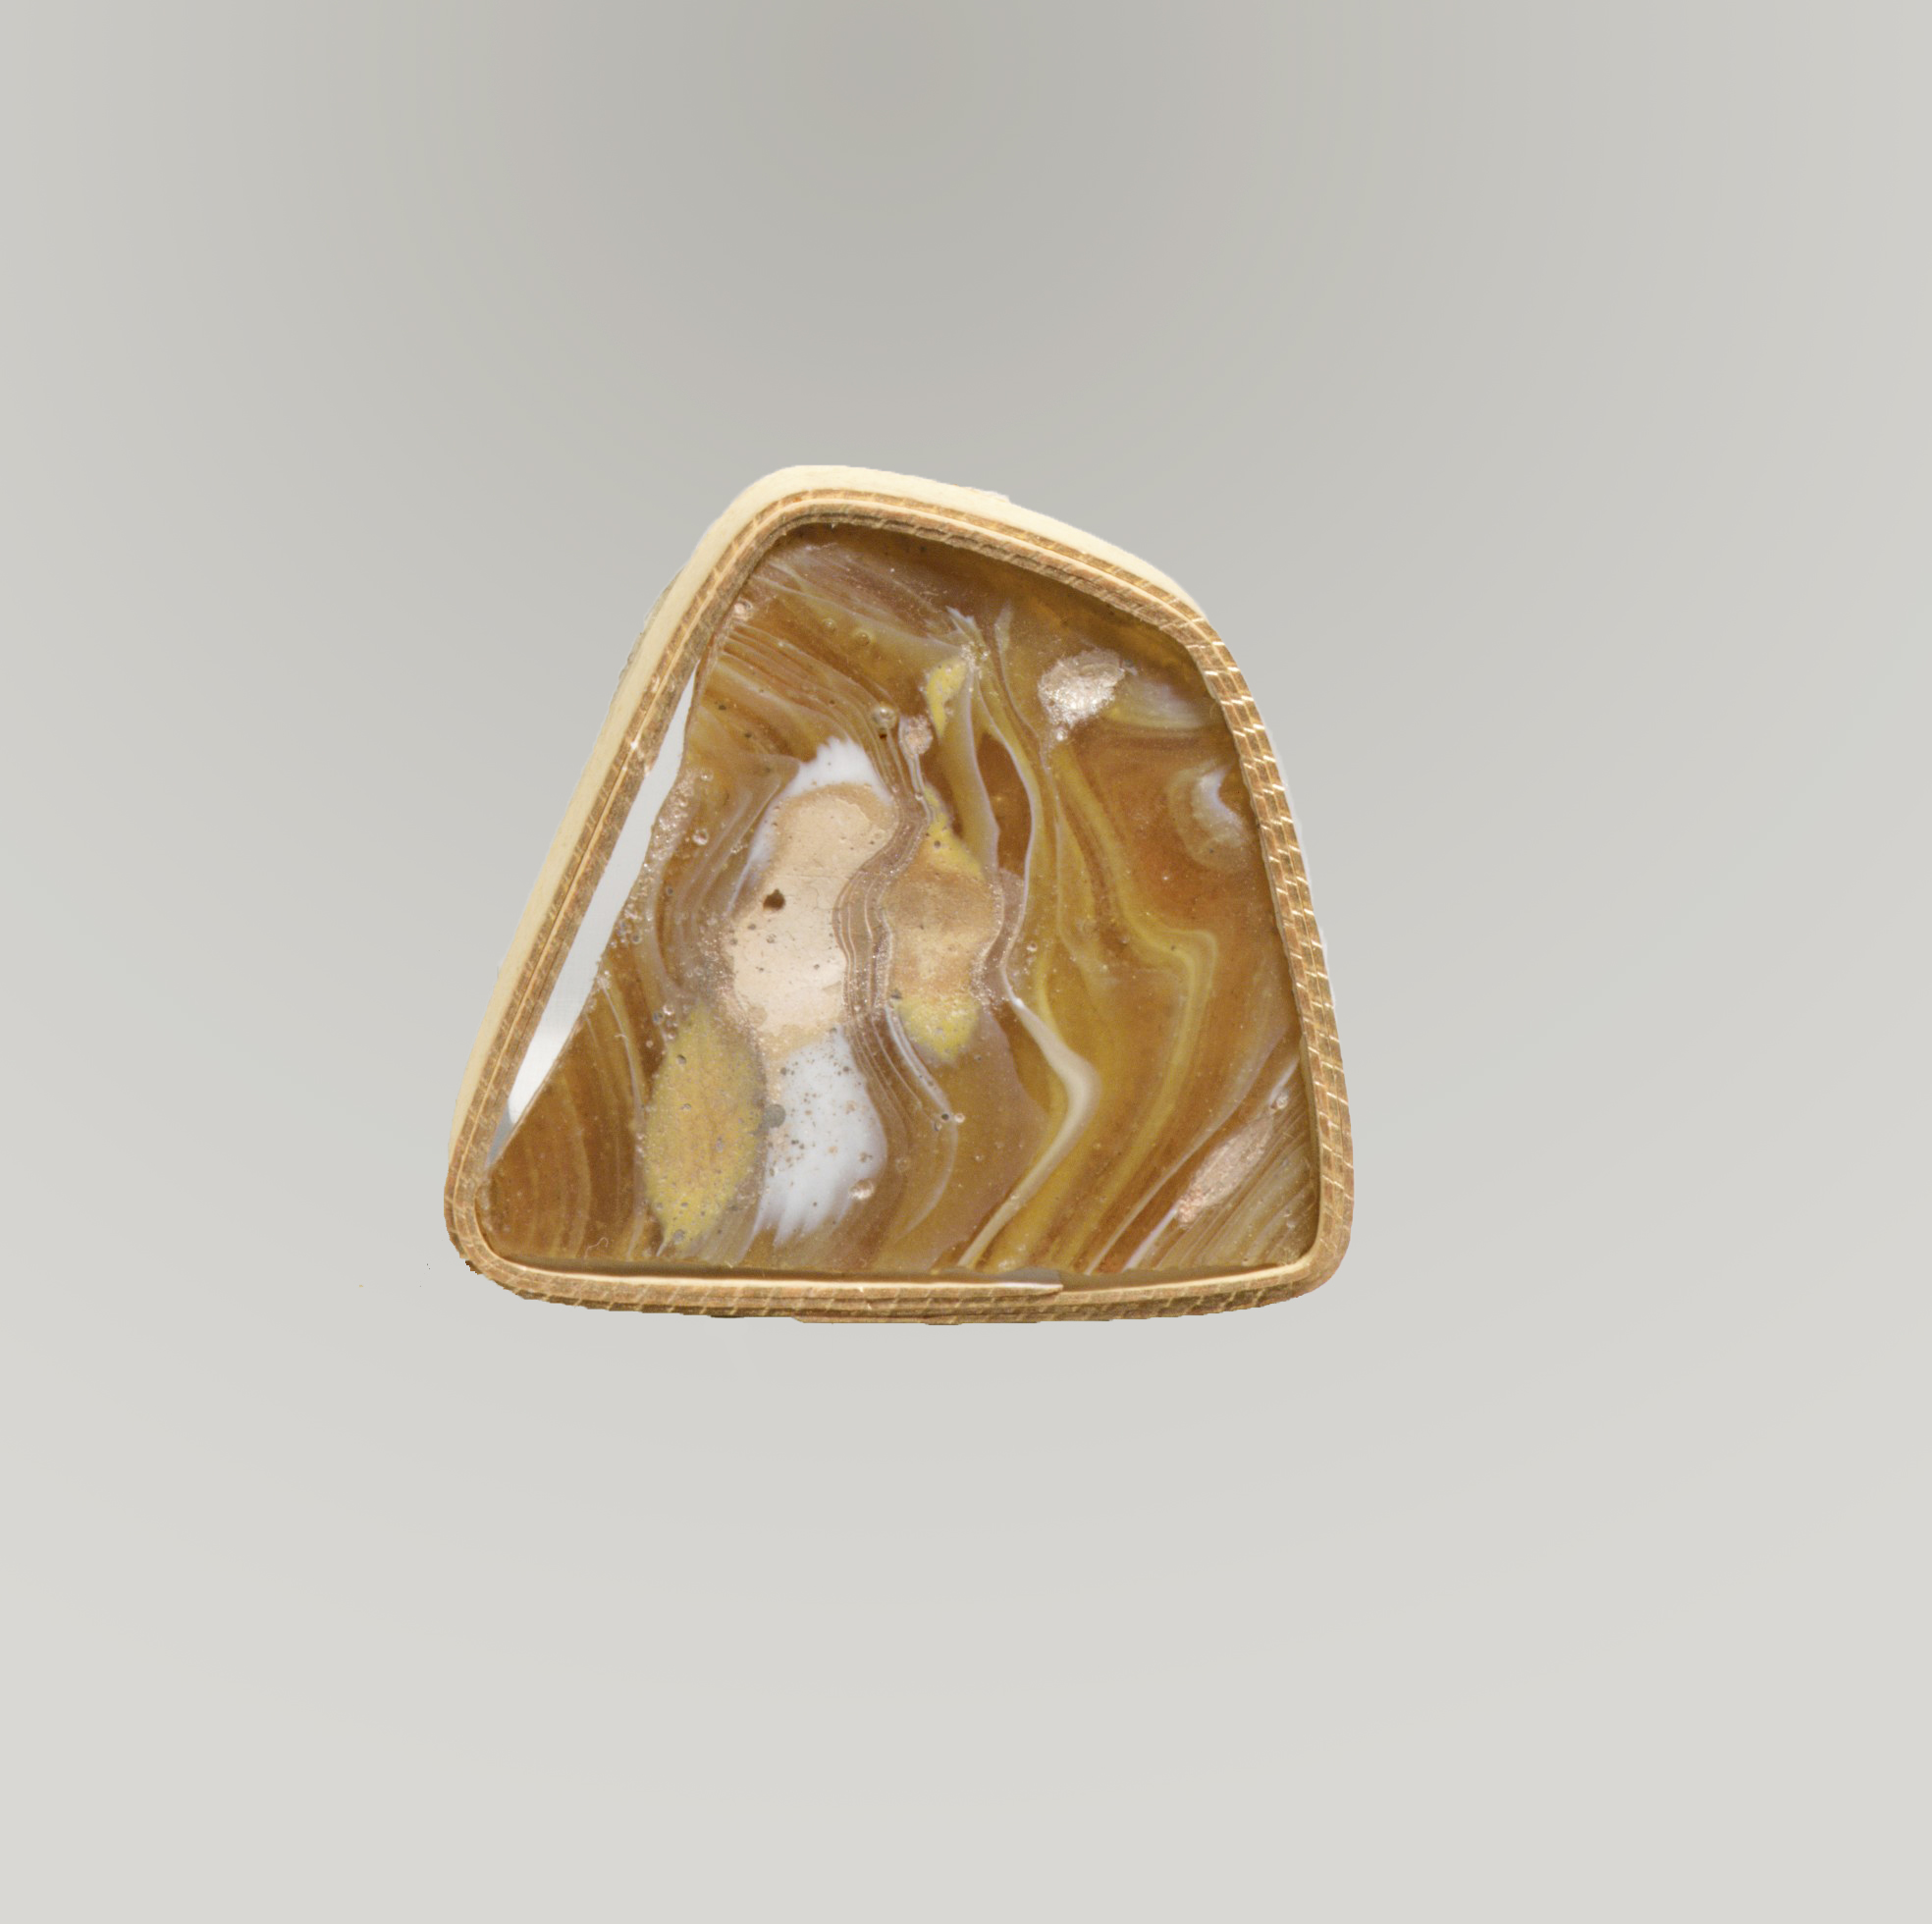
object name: fragment, mosaic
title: Glass mosaic bowl fragment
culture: roman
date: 34 BCE-33 CE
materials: glass